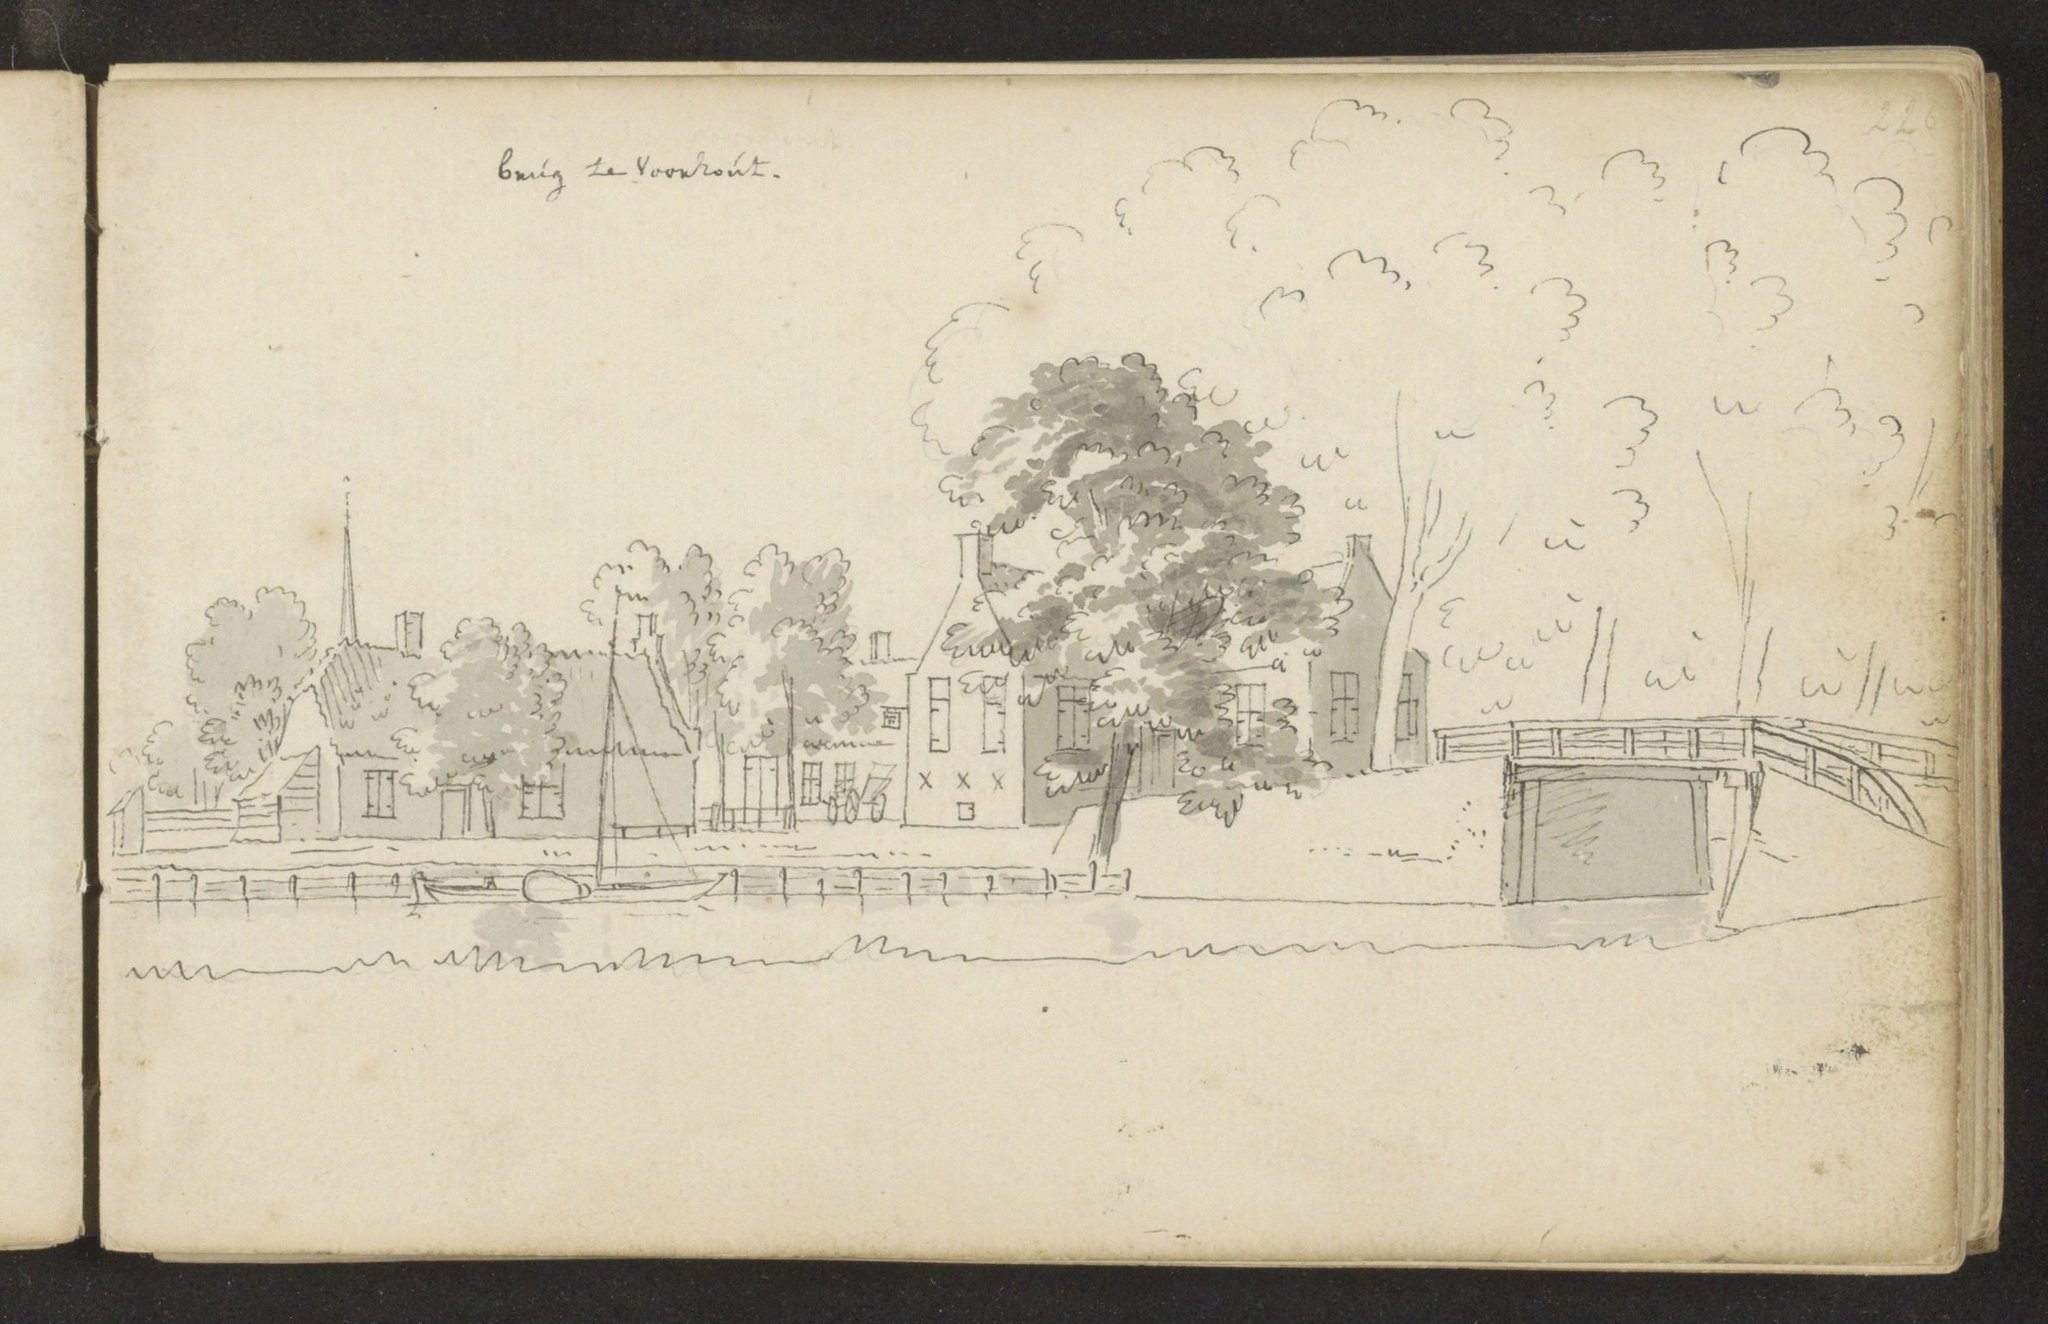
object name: sketchbook leaf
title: Dorpsgezicht met brug te Voorhout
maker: abraham de haen (ii)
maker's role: draughtsman, print maker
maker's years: 1707-1748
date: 1731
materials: ink, paper, pencil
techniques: brush, pen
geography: voorhout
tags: village, bridge in village across river, canal, etc.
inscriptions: annotation: ‘brug te Voorhout’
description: Blad 22 recto uit een schetsboek met 78 bladen.